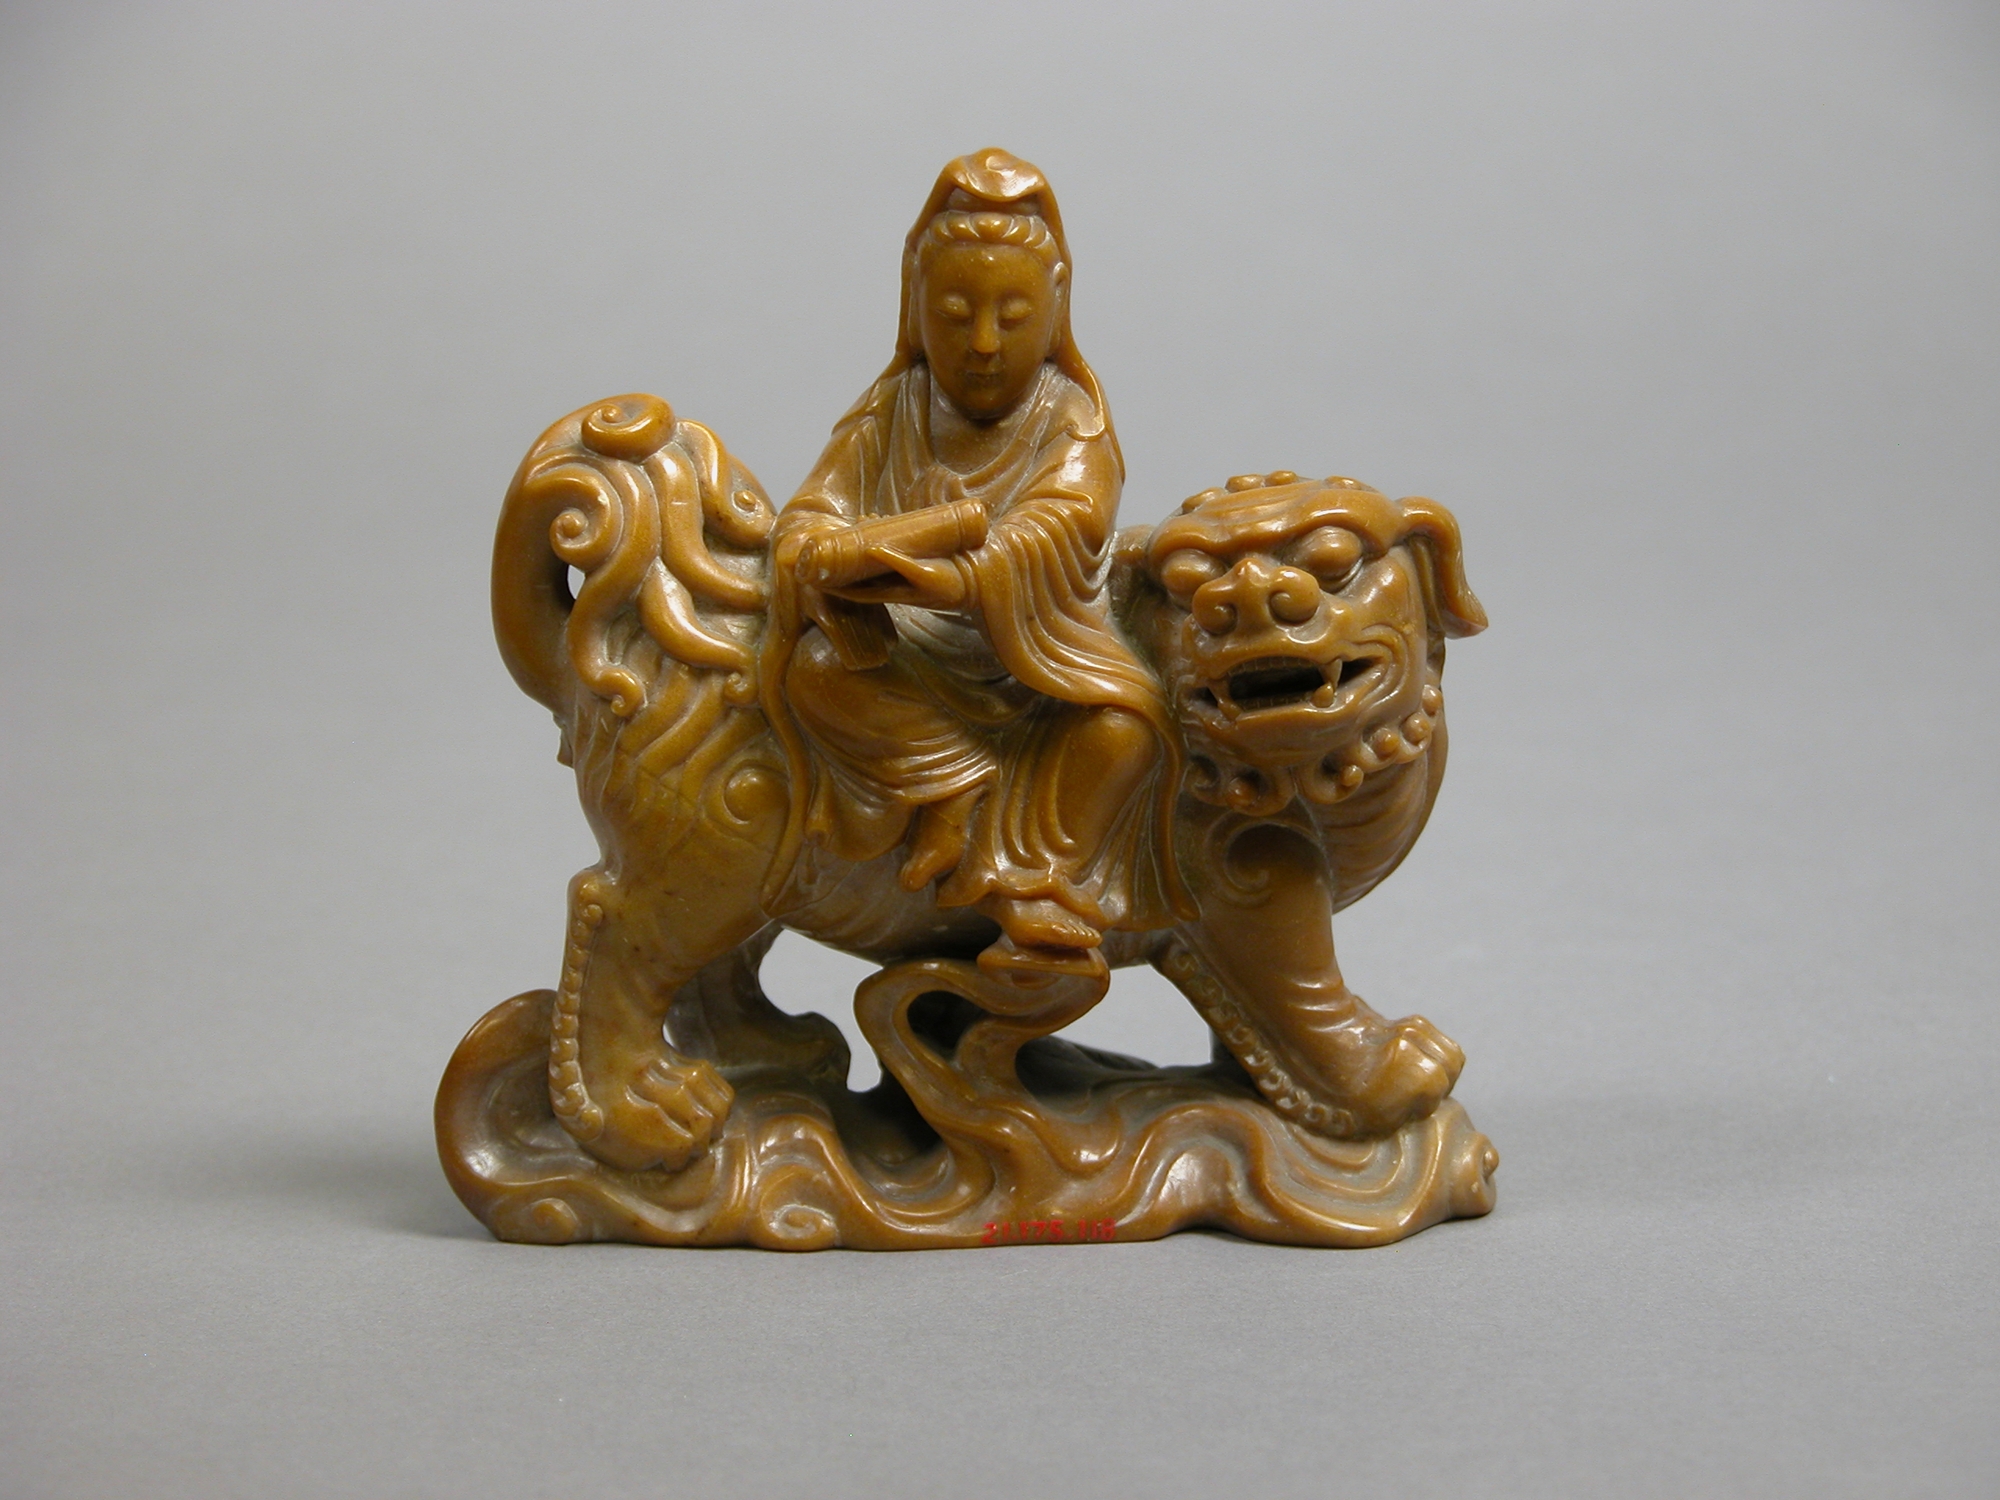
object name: ornament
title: Manjusri riding a lion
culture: chinese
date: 1644-1911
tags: lions,buddhism,manjushri